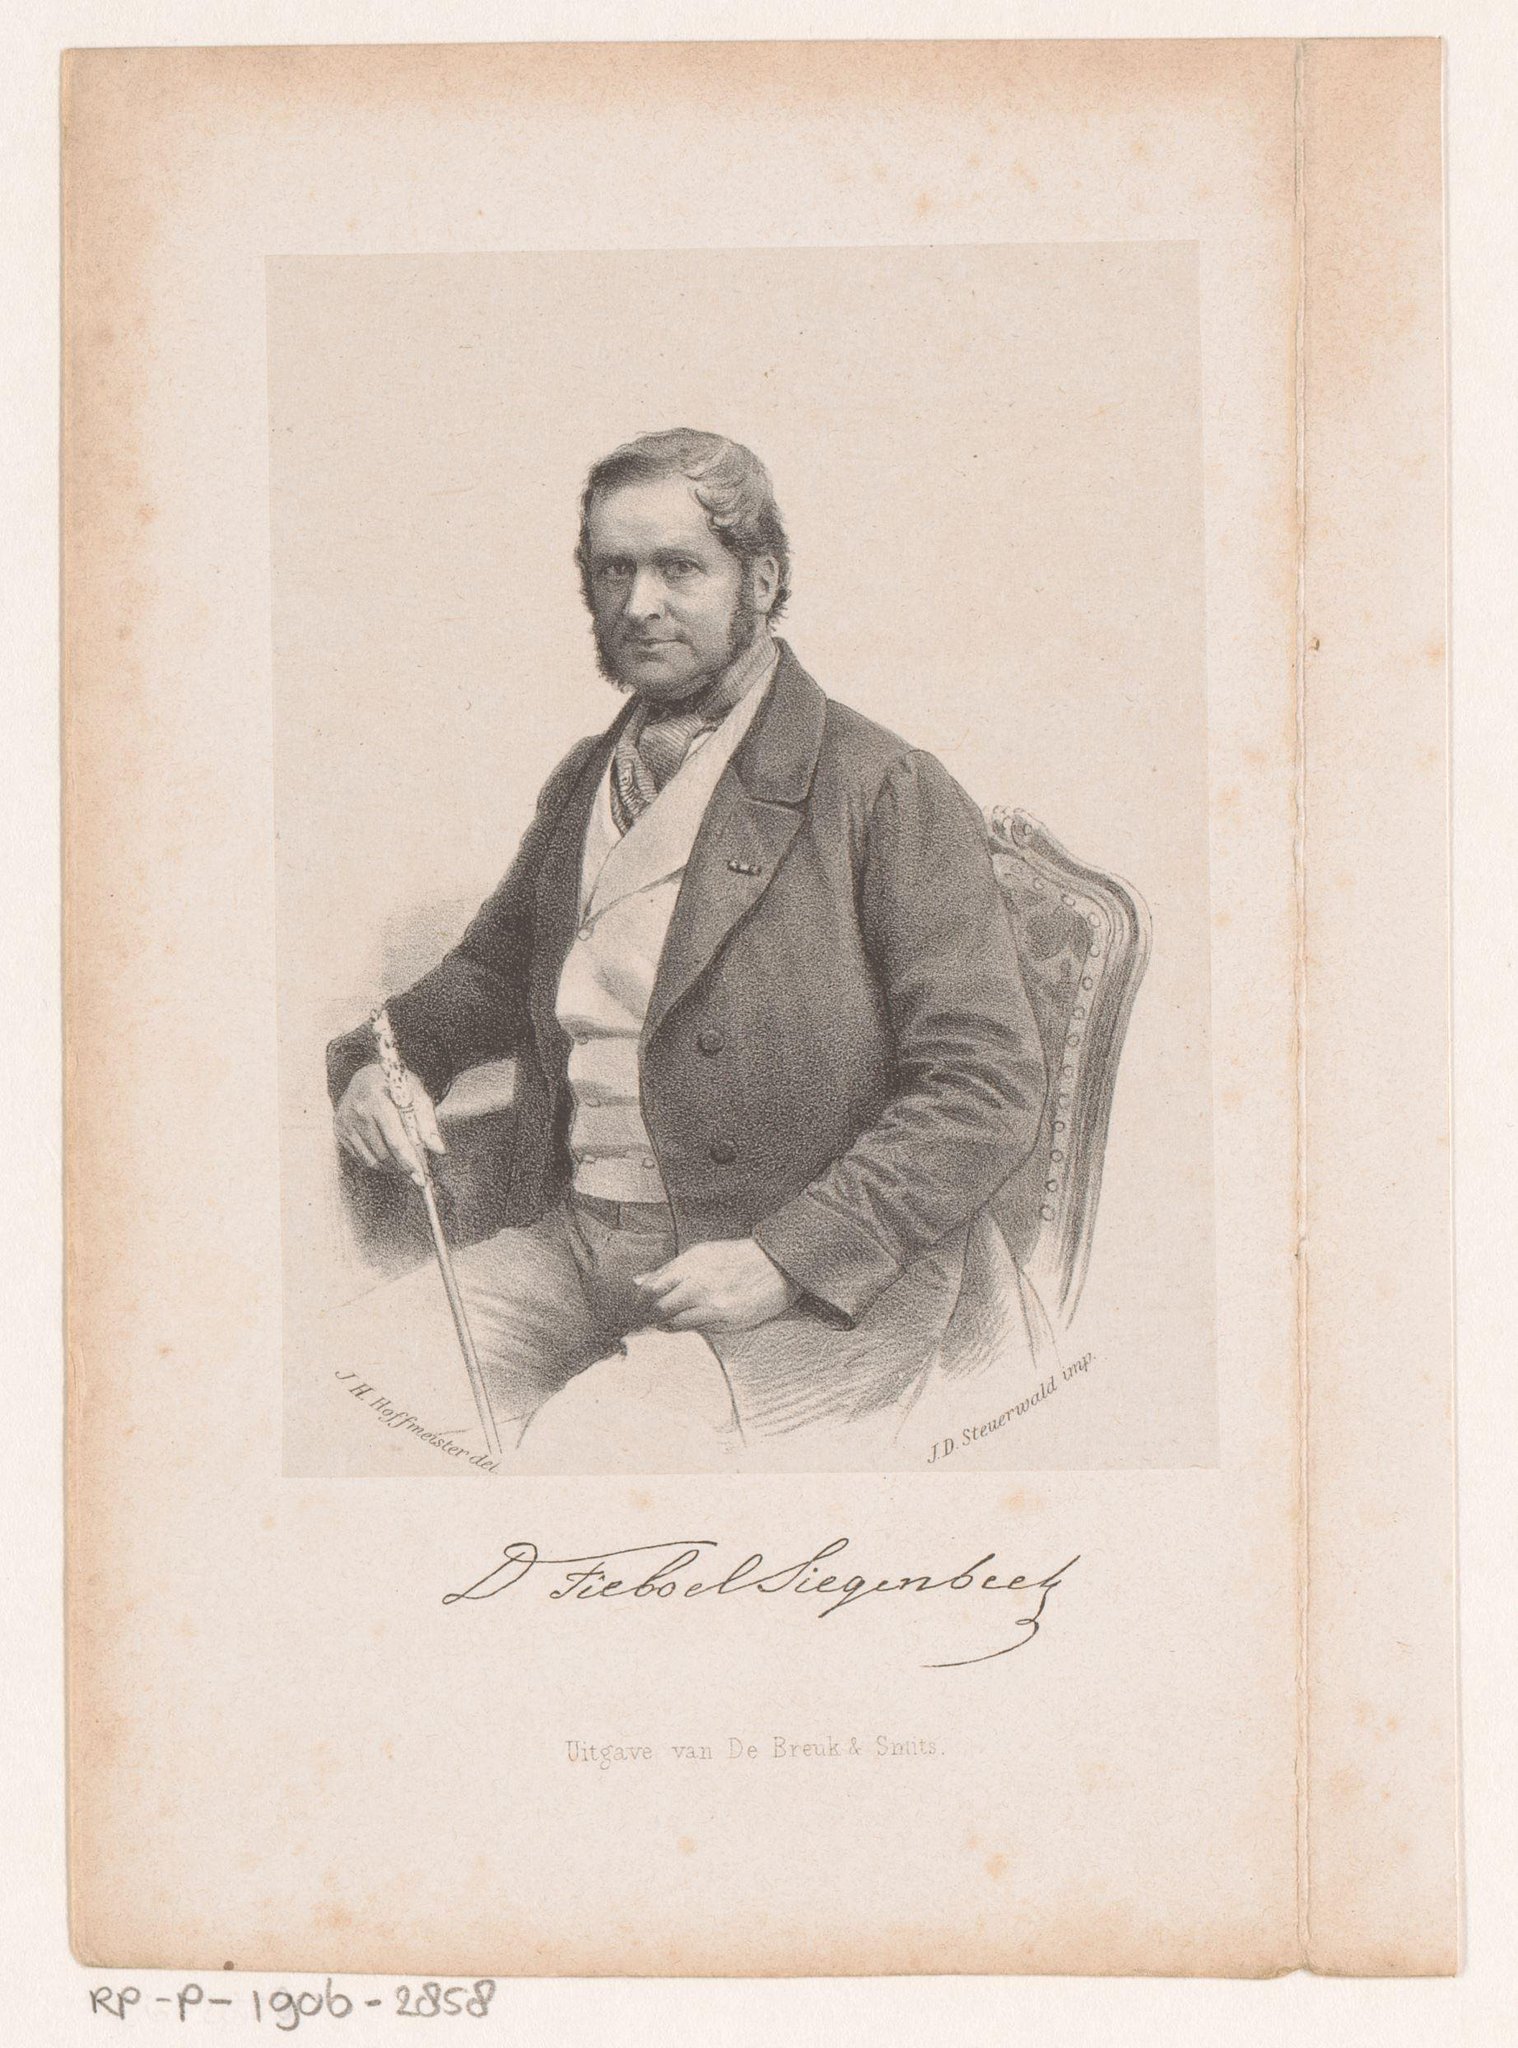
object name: print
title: Portret van Daniel Tieboel Siegenbeek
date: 1843-1863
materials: paper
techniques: lithograph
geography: netherlands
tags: leiden, mayor, walking-stick, staff, historical persons (+ half-length portrait)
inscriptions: collector's mark: Lugt 2228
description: De geportretteerde heeft een wandelstok in zijn rechterhand. Onder het portret zijn signatuur.